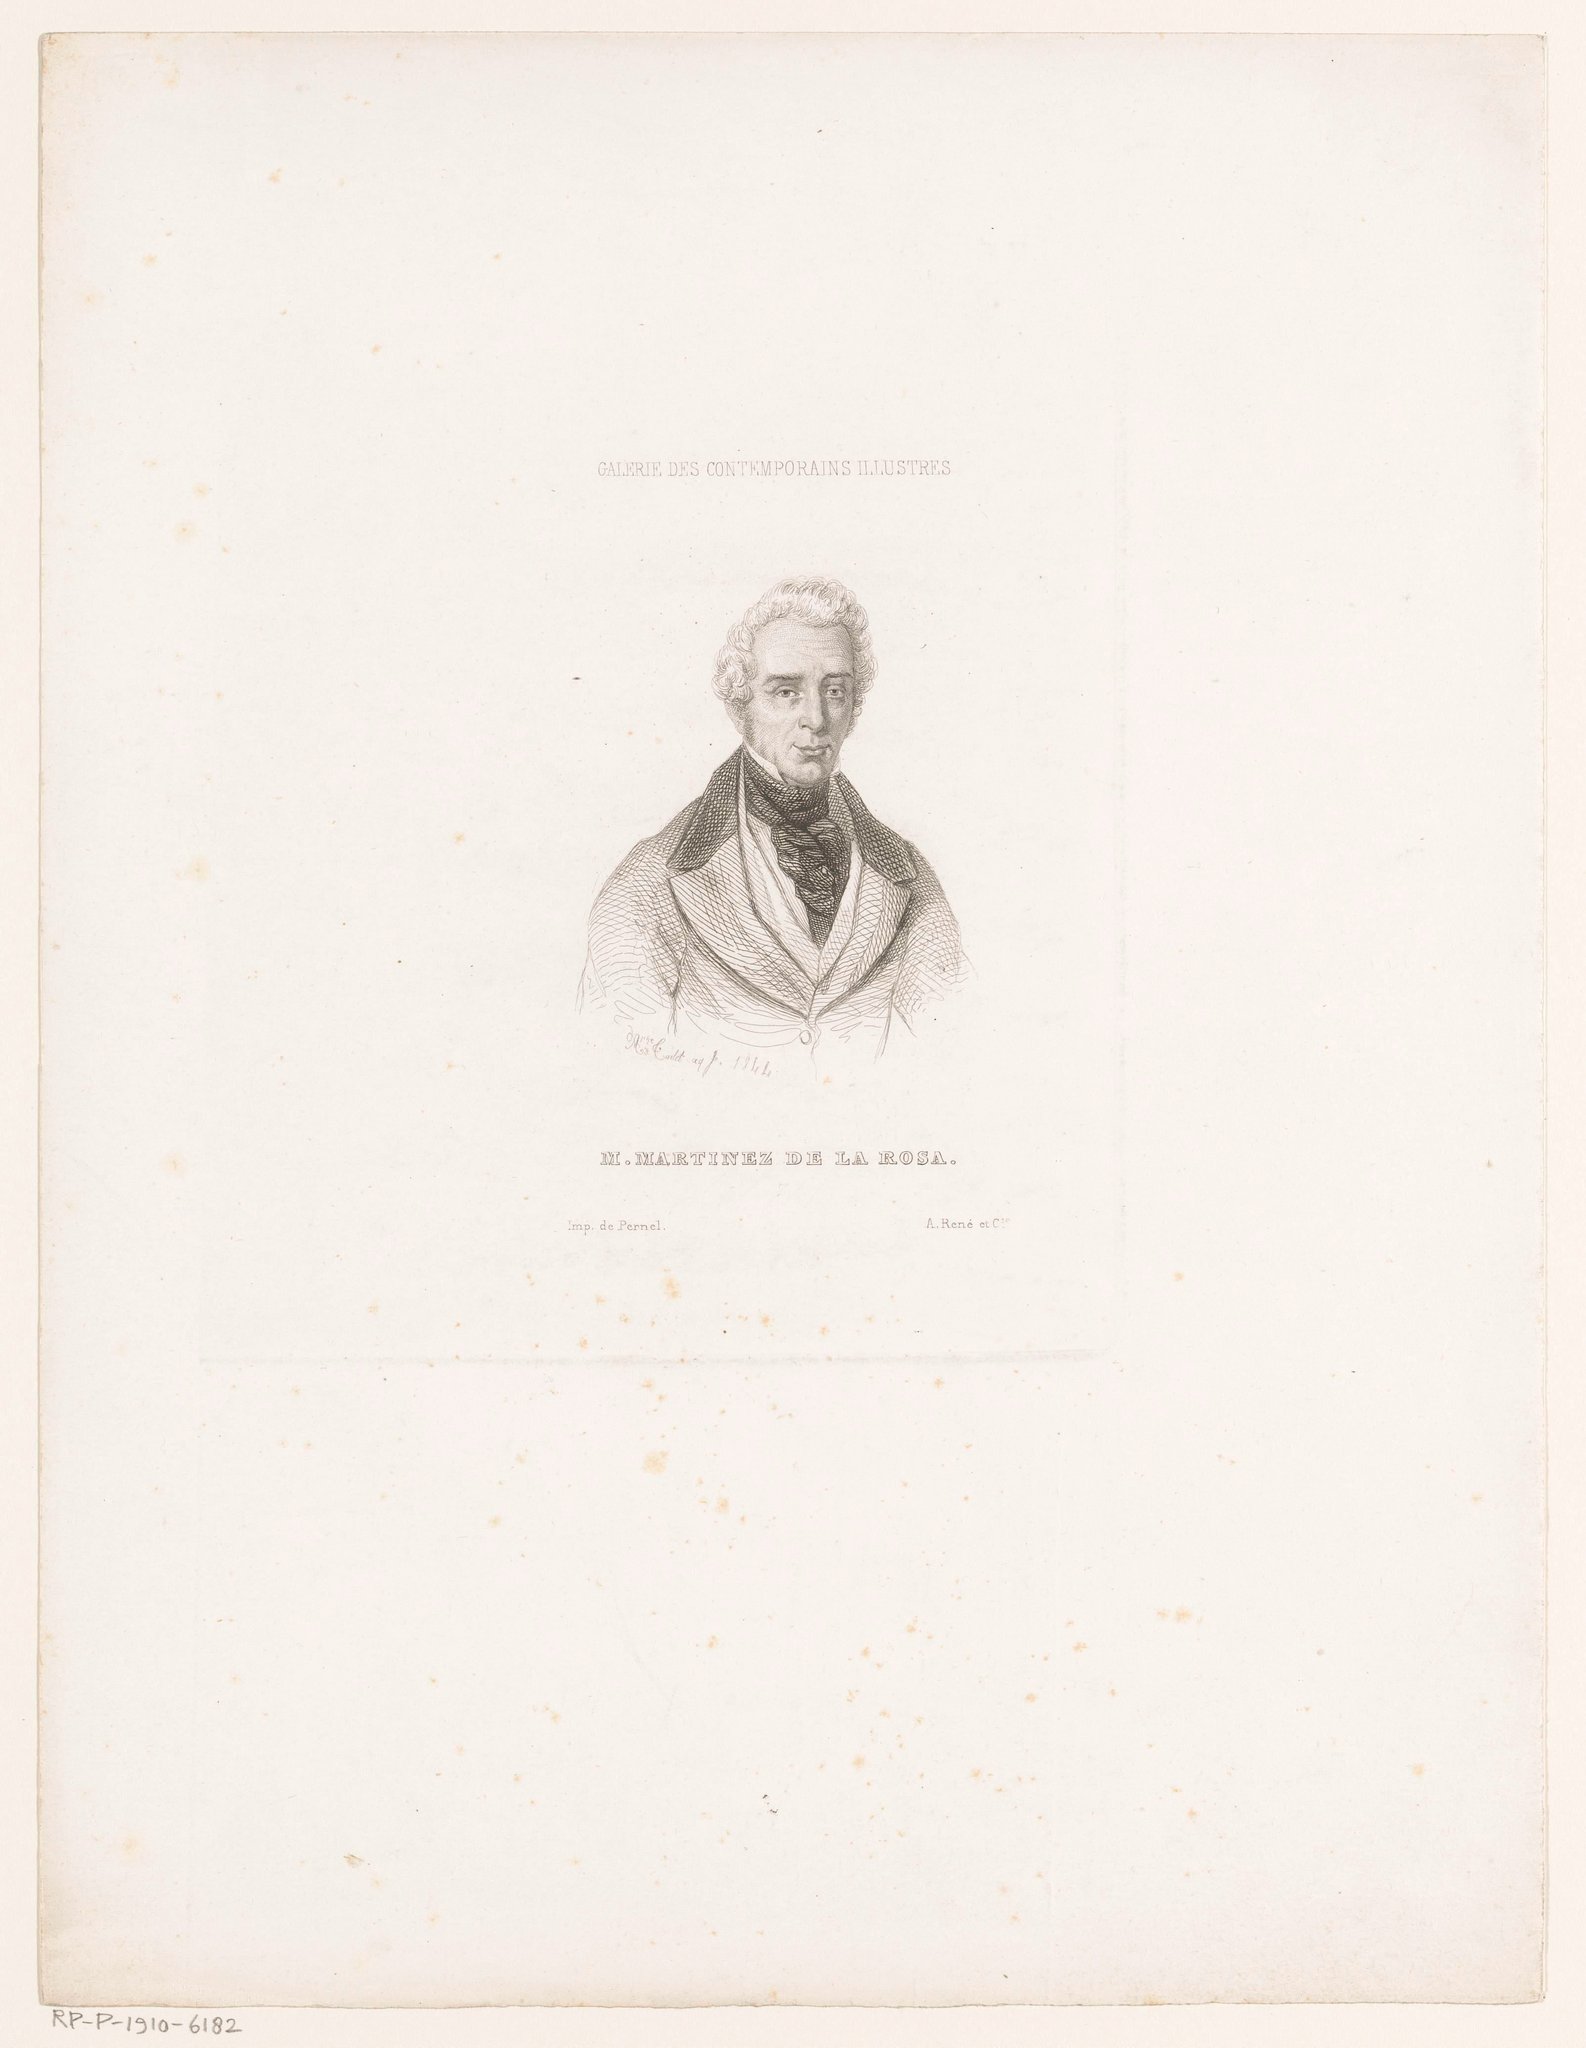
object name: print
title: Galerie des contemporains illustres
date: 1844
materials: paper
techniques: etching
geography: paris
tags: politician, minister ~ government, historical persons, writer, poet, author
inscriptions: collector's mark: Lugt 2228